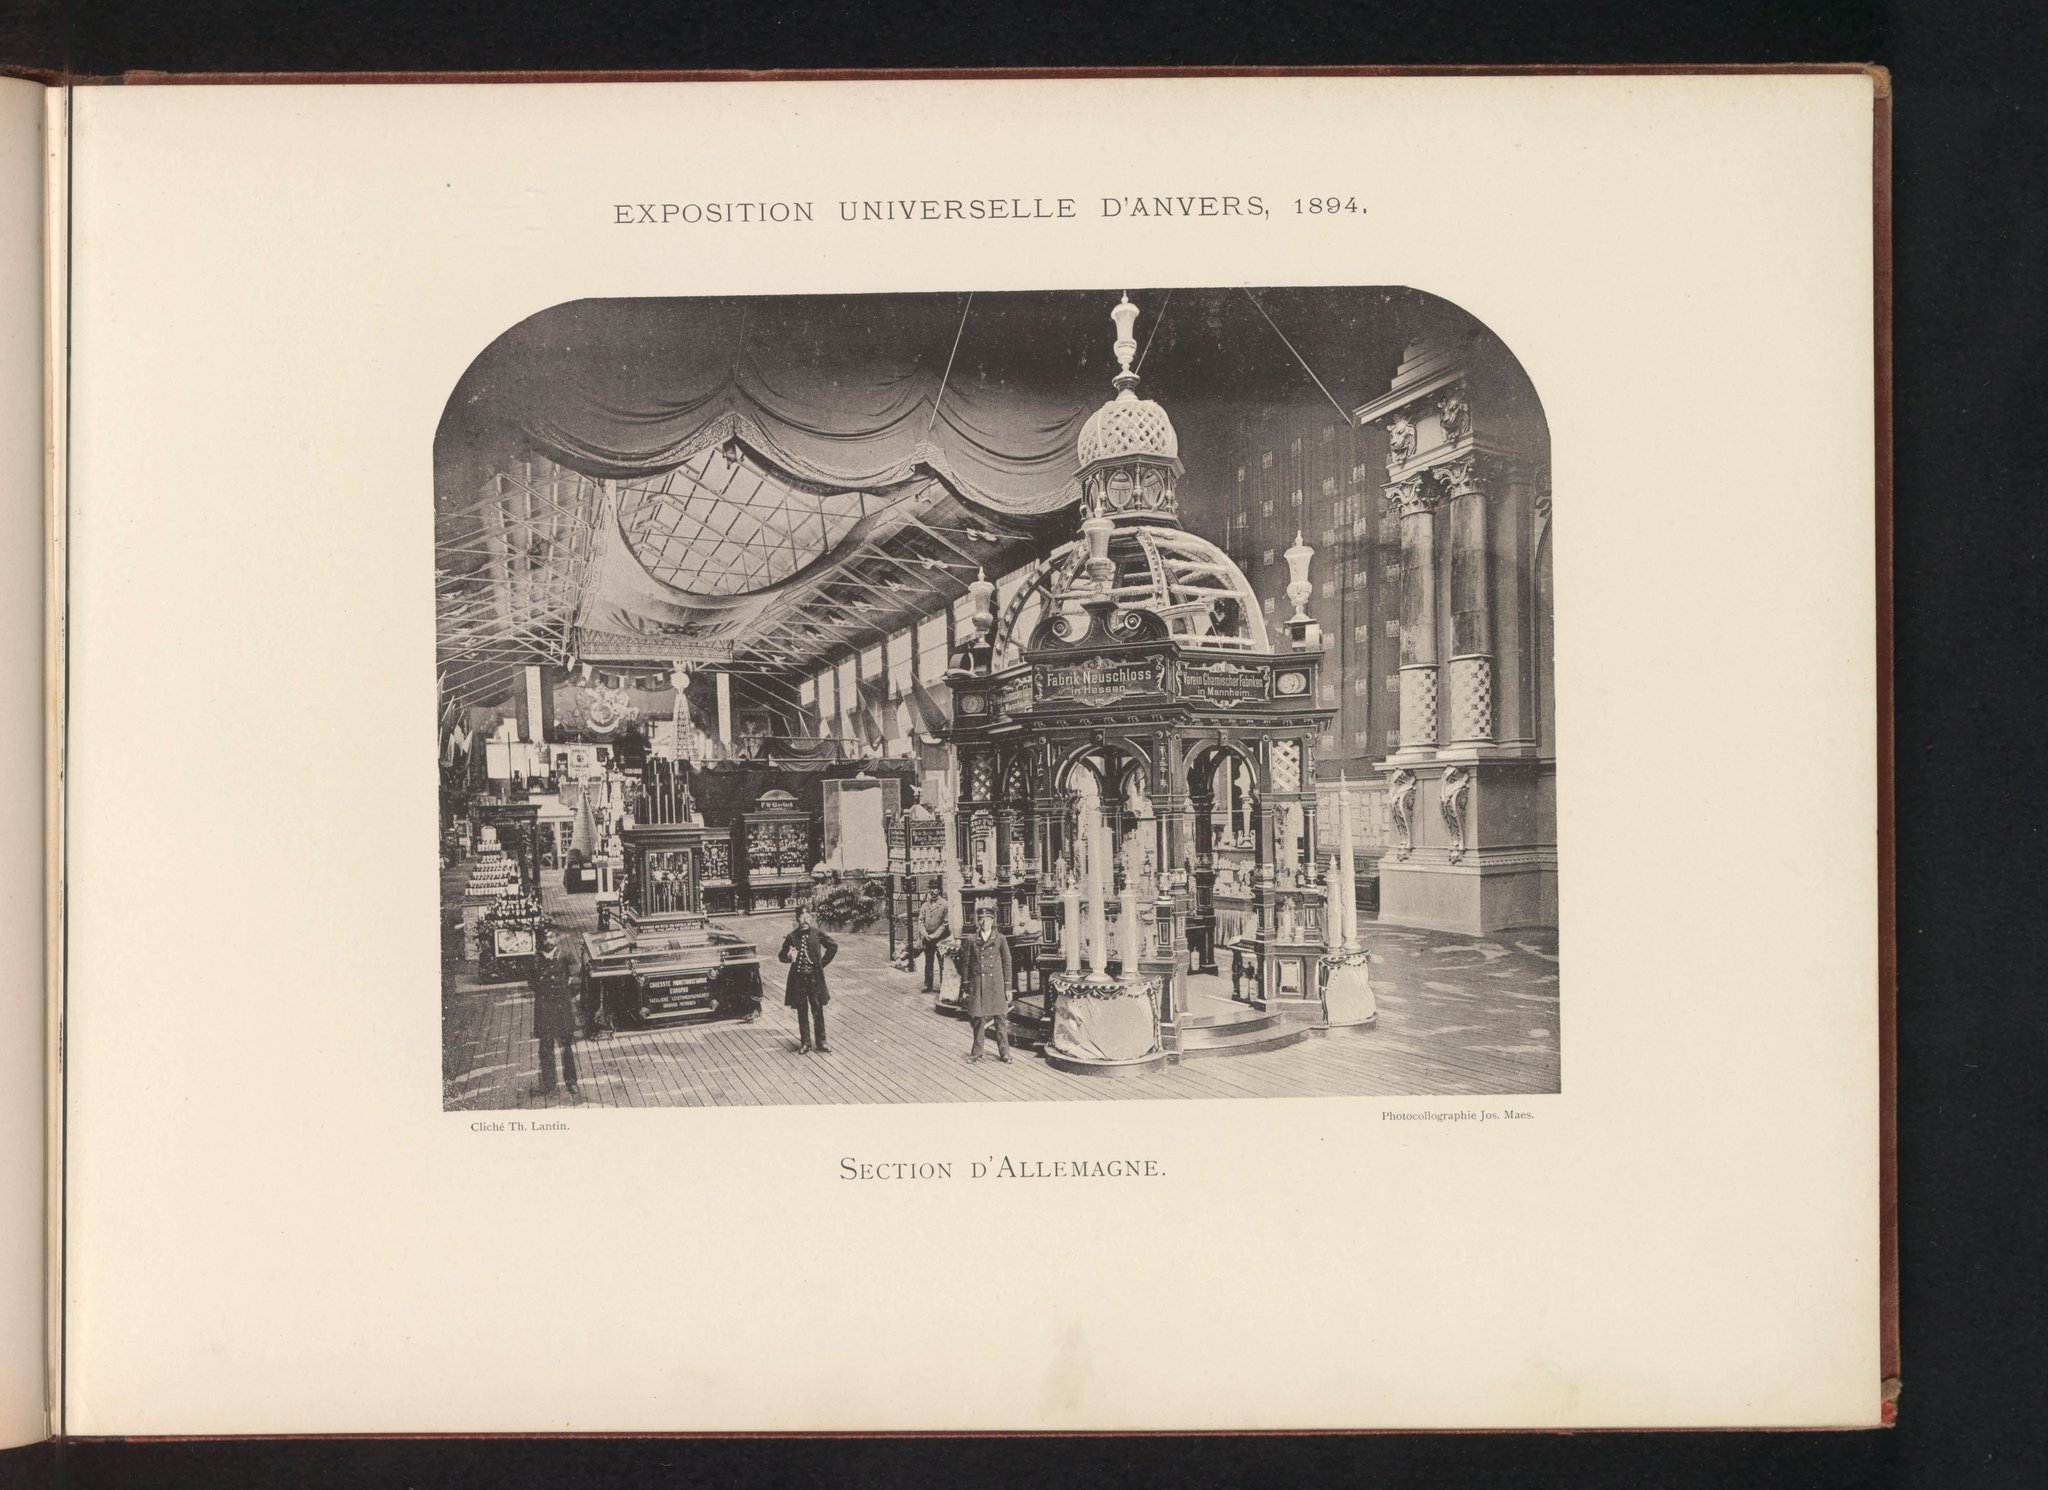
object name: photomechanical print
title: Section d'Allemagne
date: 1894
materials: paper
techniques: photograph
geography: antwerp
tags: world fair, world exhibition, collection, exhibition, show